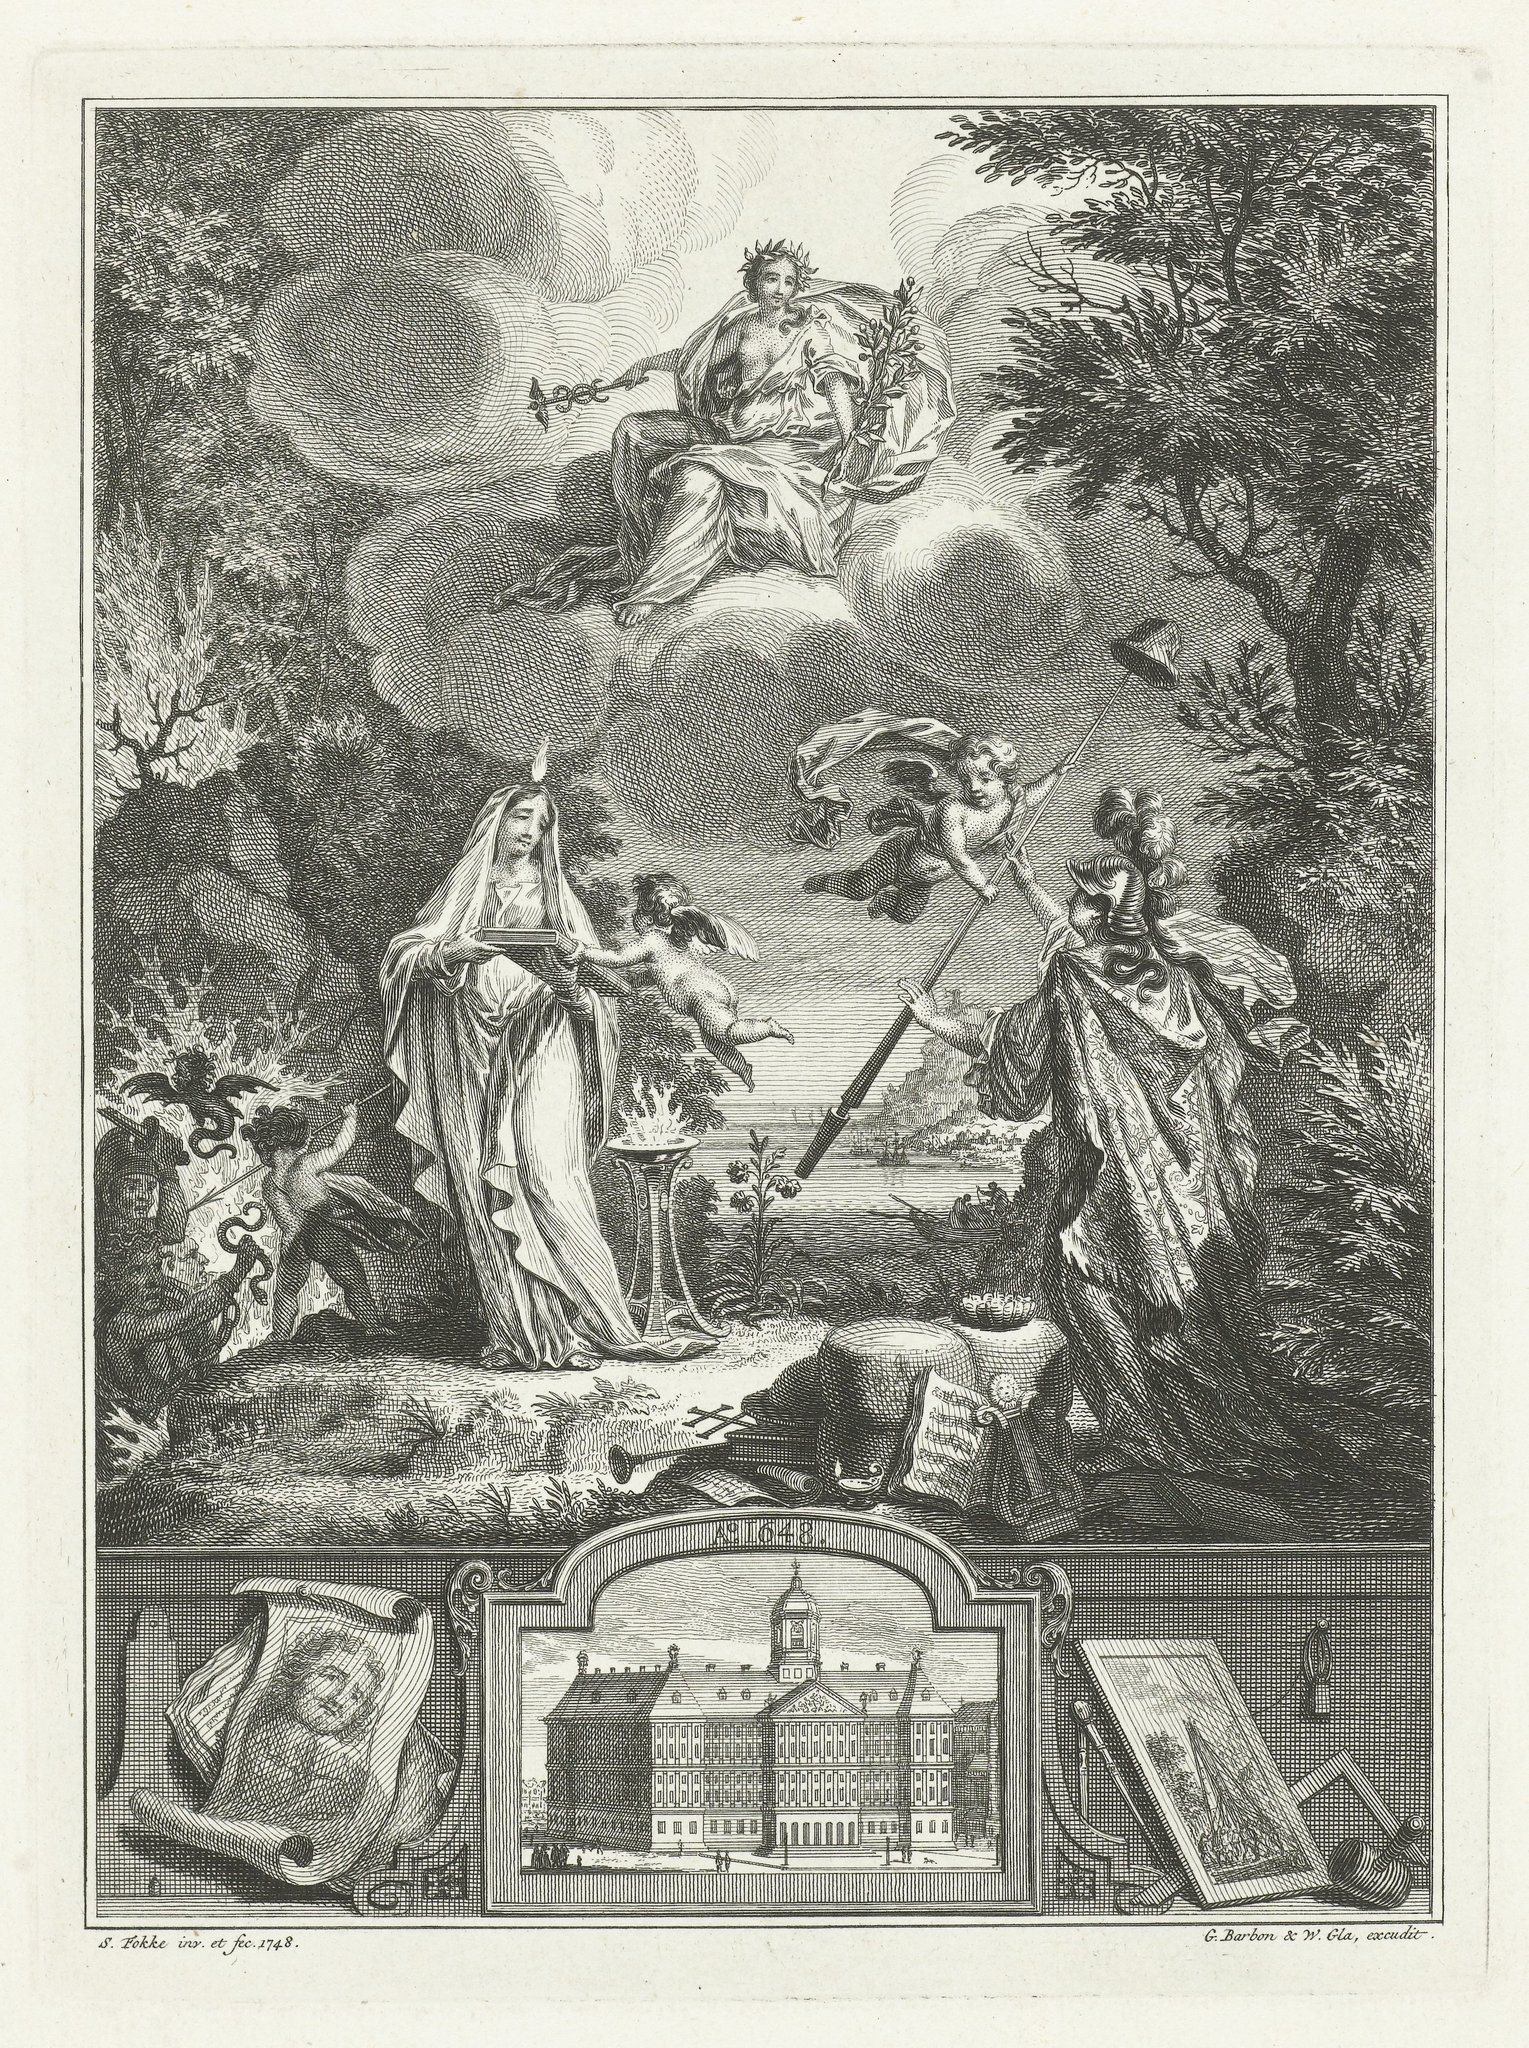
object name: print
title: Allegorie op het 100-jarig jubileum van Nederlands Vrijheid, 1648-1748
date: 1748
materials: paper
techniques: engraving, etching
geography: northern netherlands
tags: haarlem, print maker, draughtsman, jacob van campen, freedom, liberty; 'libertà' (ripa)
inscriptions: collector's mark: Lugt 2228, inscription: ‘6 stuks 32.’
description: De gelauwerde personificatie van de Vrede troont in de lucht met een olijftak en een caduceus. Onder haar ontvangt Minerva een lans met vrijheidshoed van een putto. Een tweede putto biedt de Waakzaamheid in het midden een boek aan. Geheel links jaagt een derde putto duivelse figuren met een speer een vlammenzee in. Aan de onderzijde het in 1648 voltooide Stadhuis op de Dam te Amsterdam met een portret van Jacob van Campen en een voorstelling van heiwerkzaamheden bij de bouw.